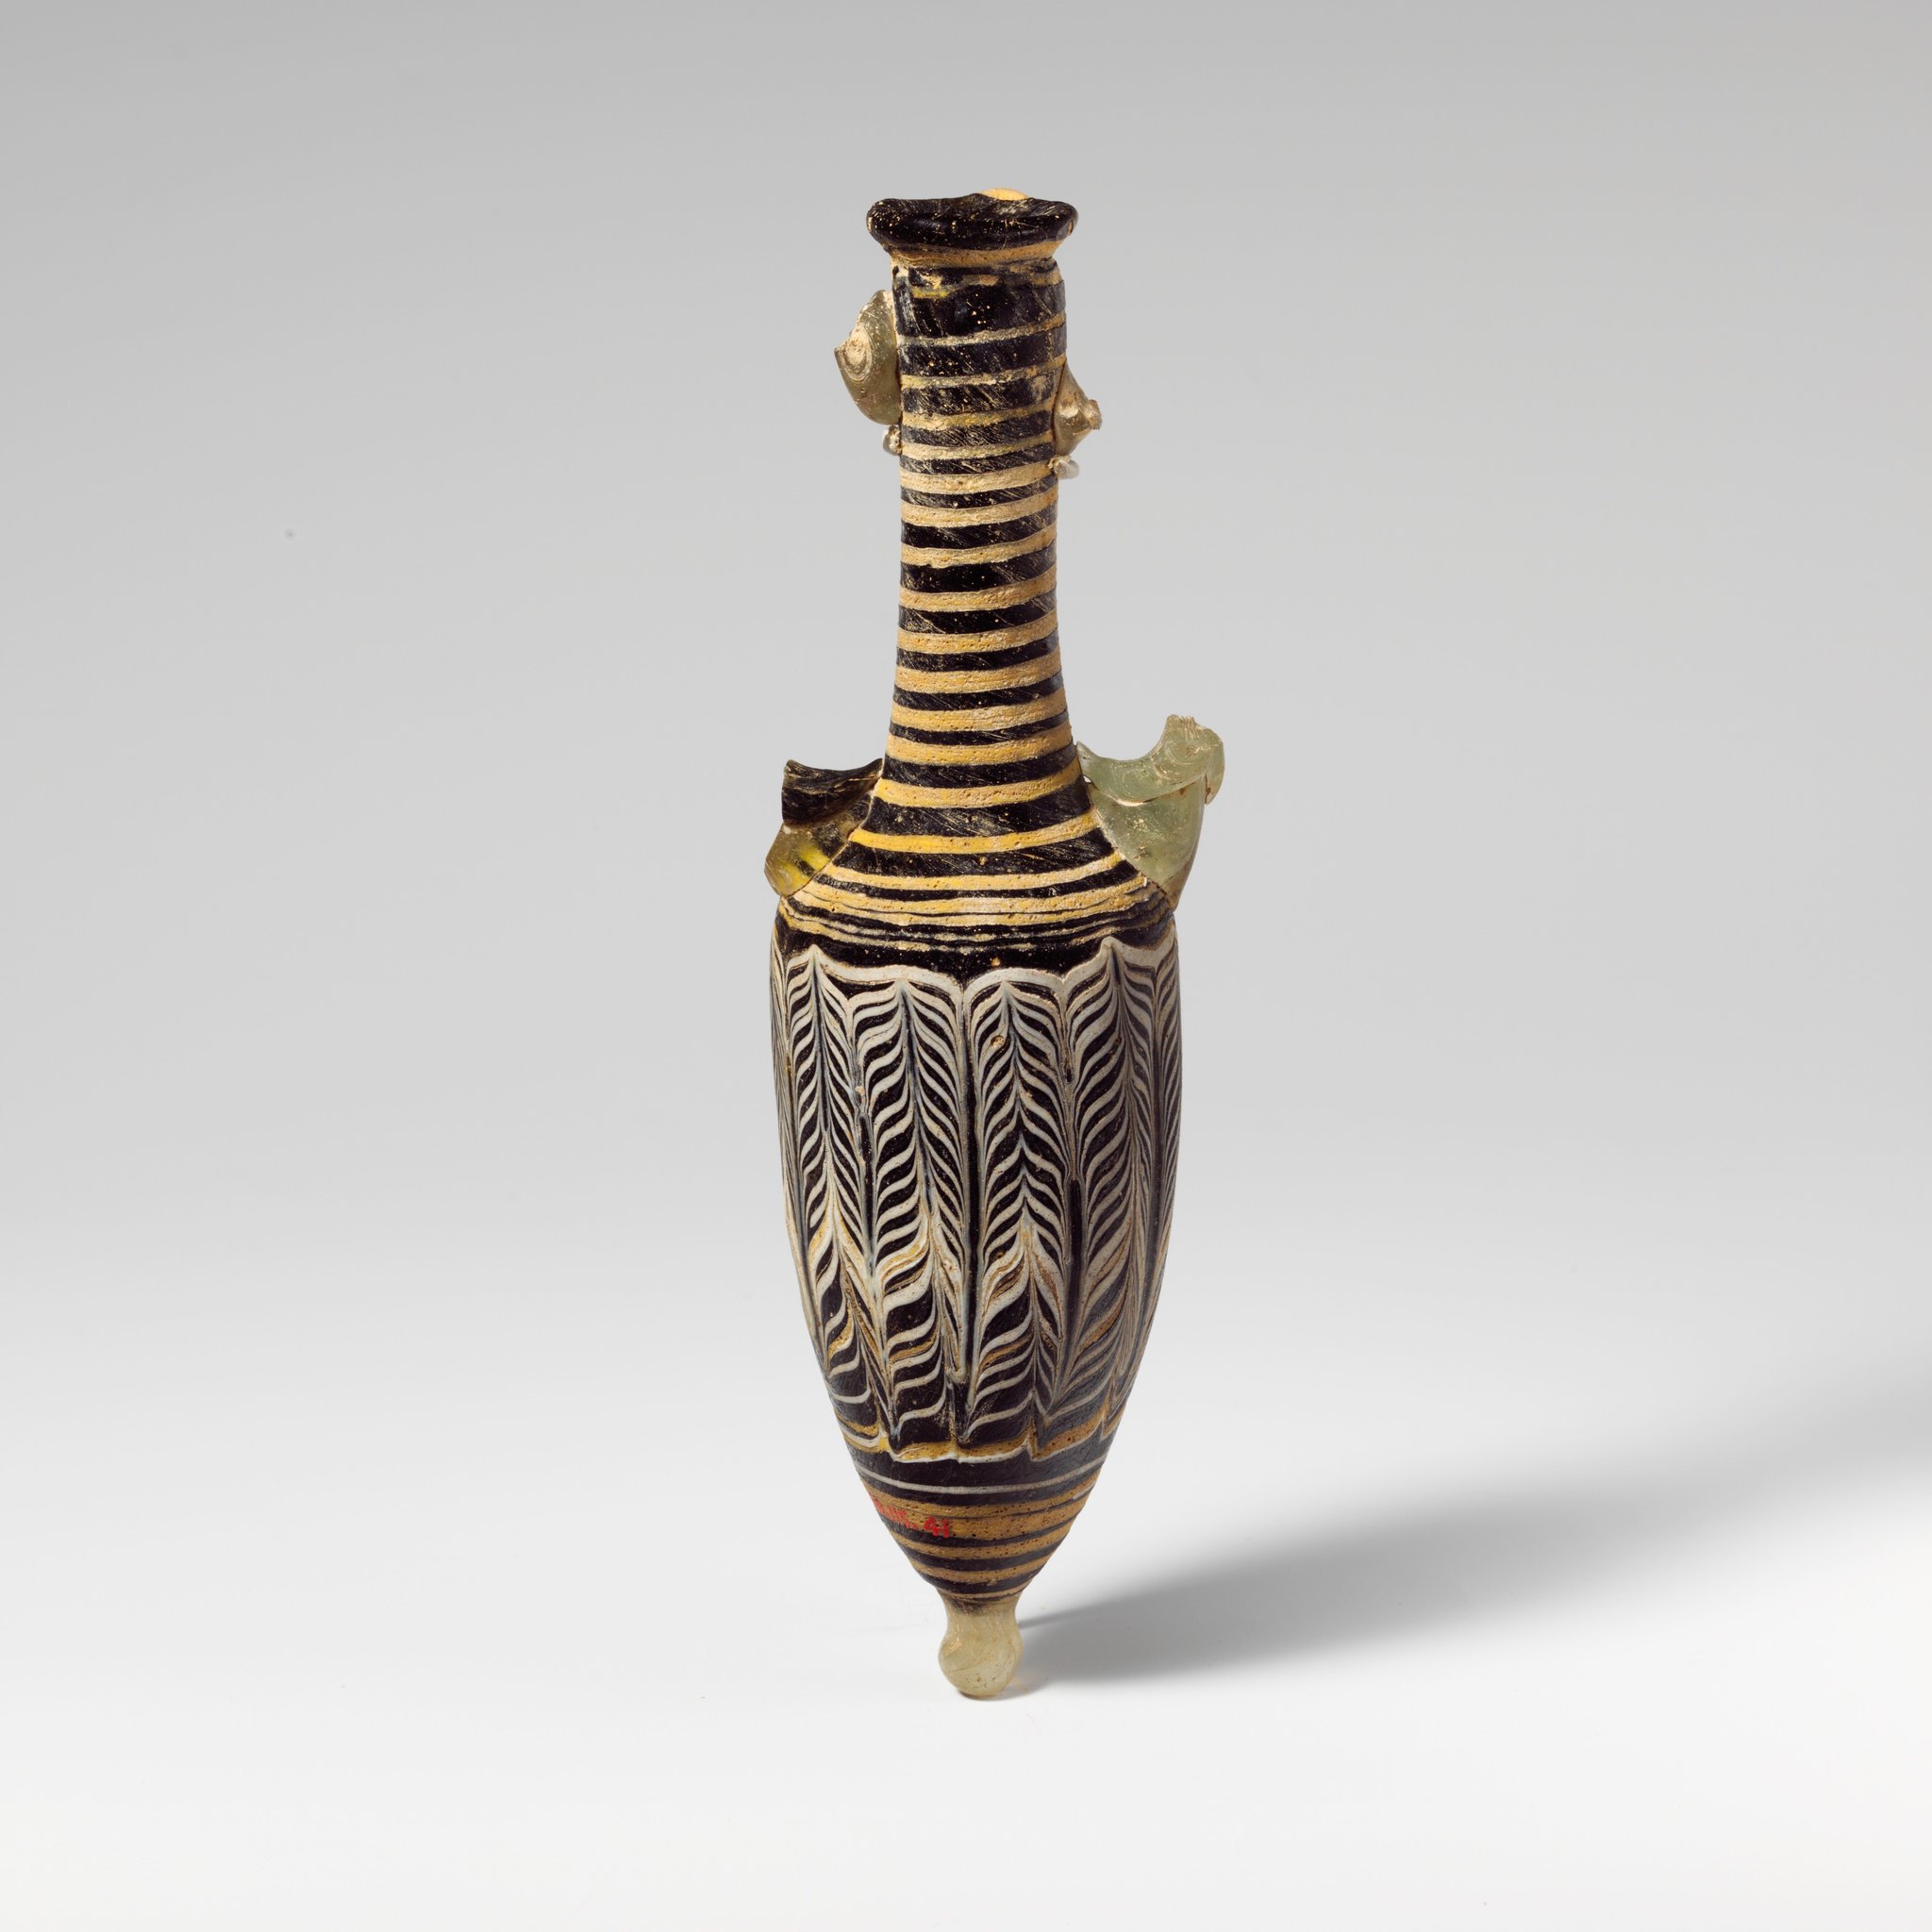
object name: amphoriskos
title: Glass amphoriskos (perfume bottle)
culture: greek, eastern mediterranean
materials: glass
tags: leaves